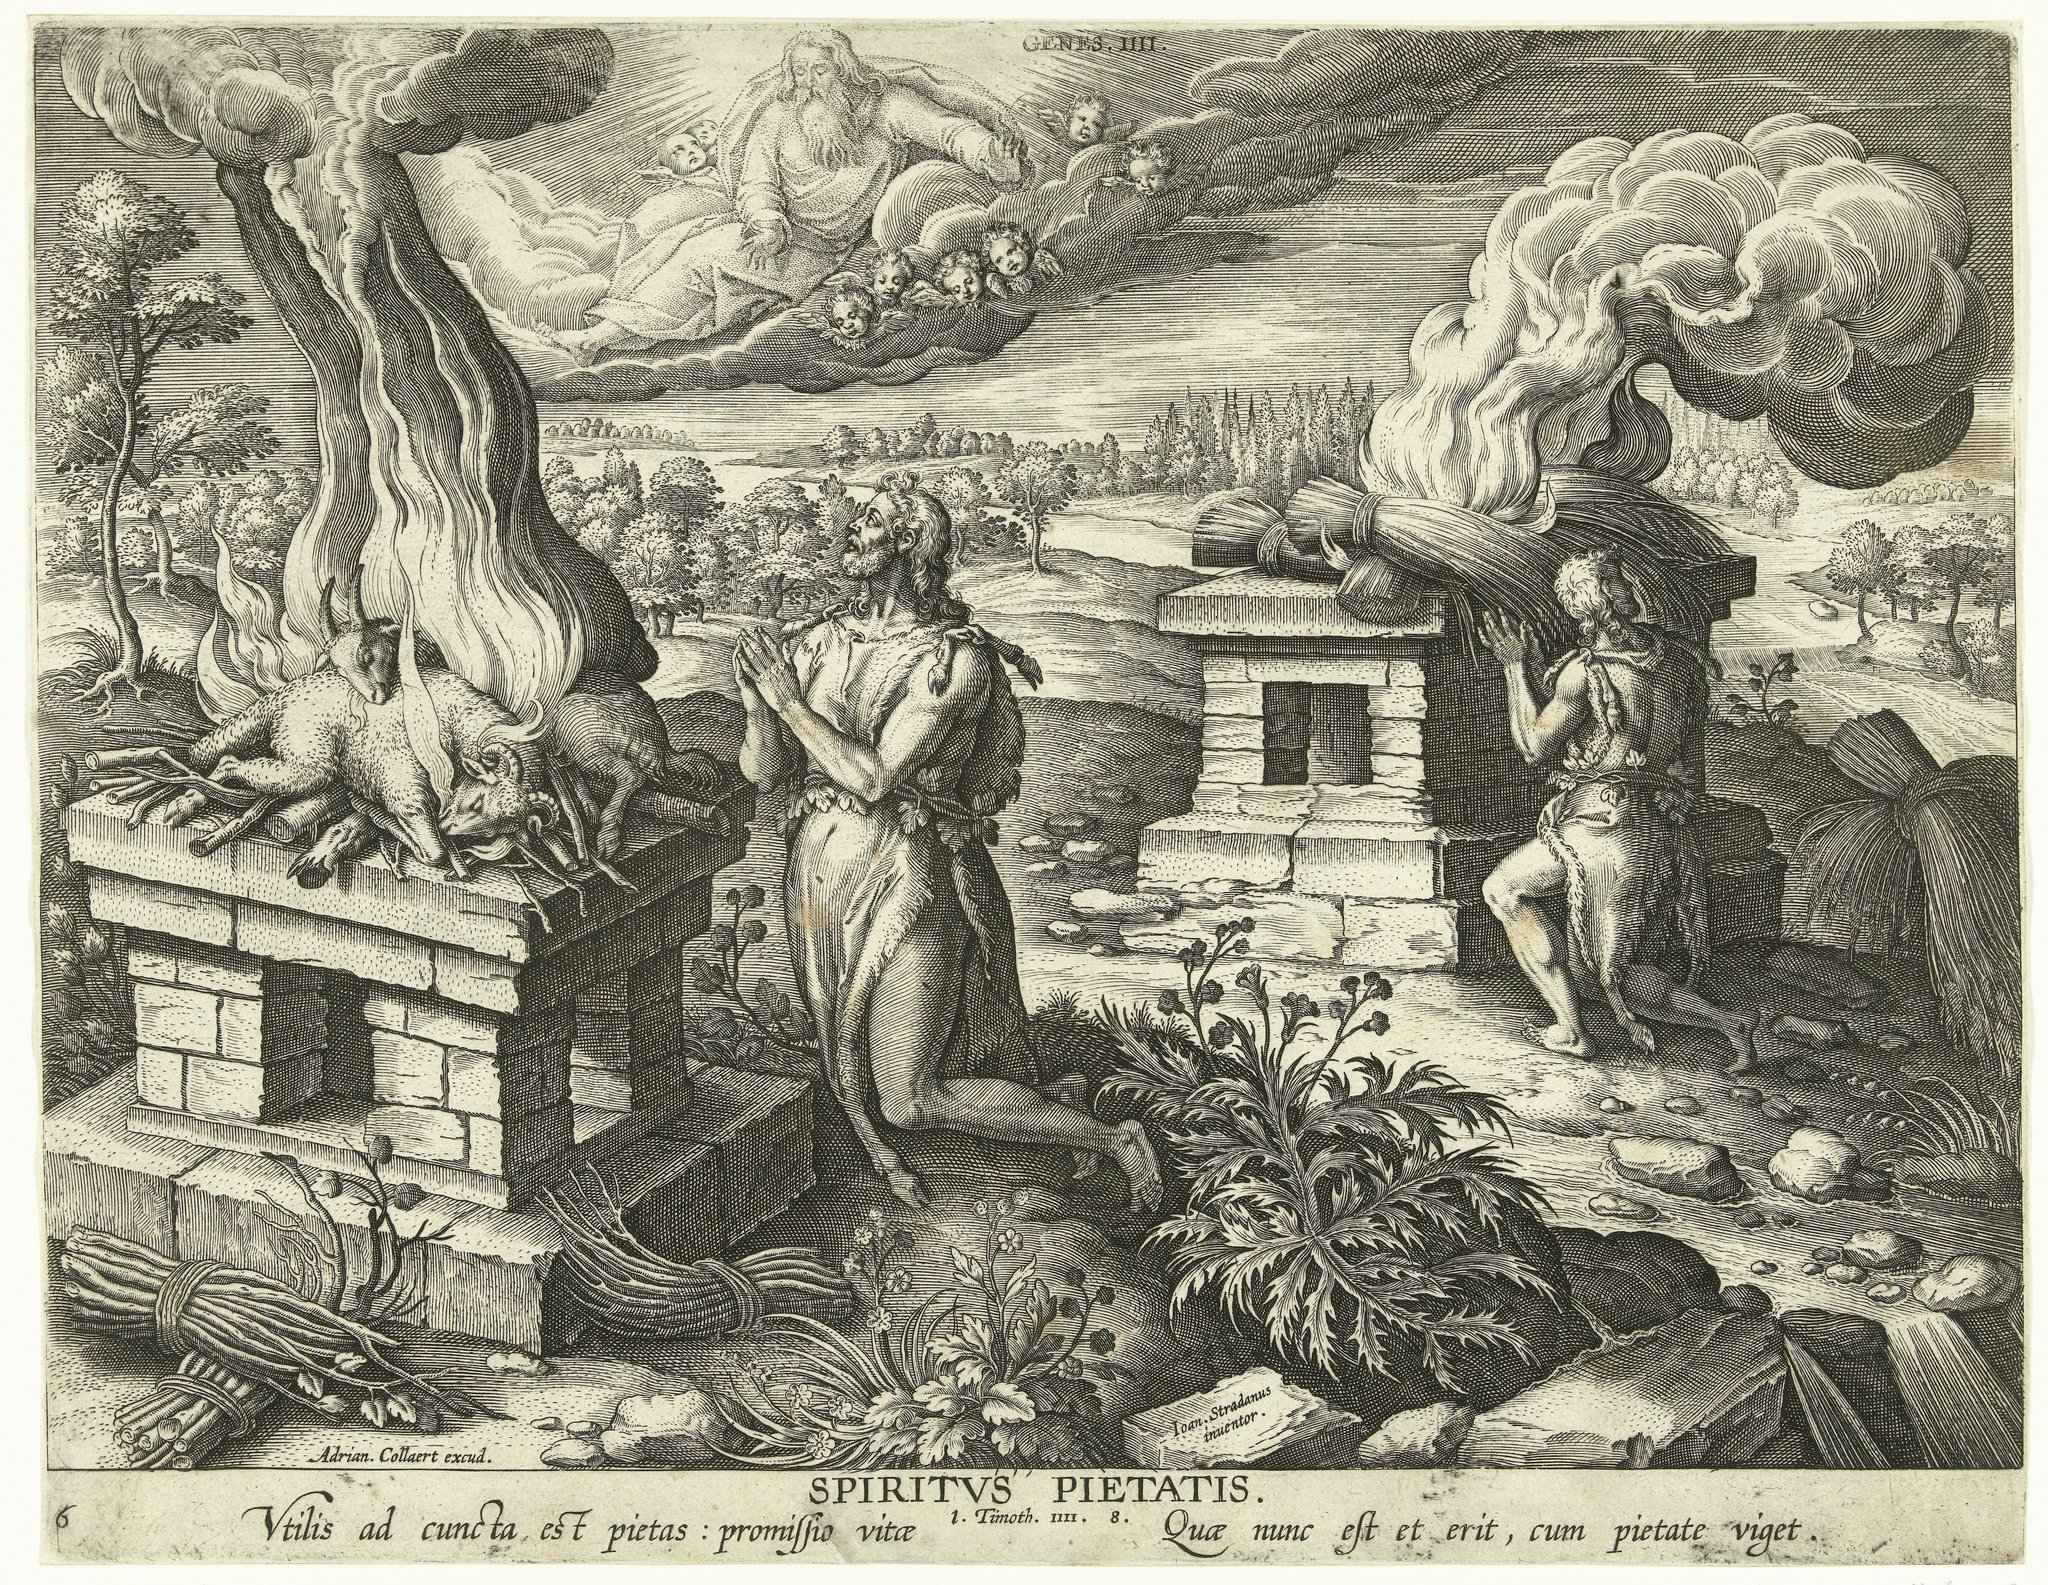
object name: print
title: Zeven gaven van de Heilige Geest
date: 1593-1597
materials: paper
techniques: engraving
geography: antwerp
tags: the fume of abel's sacrifice goes straight to heaven, whereas the smoke of cain's offering is beaten down, god (or the hand of god) appears and blesses abel ~ sacrifice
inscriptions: collector's mark: Lugt 2228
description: De offers van Kaïn en Abel (Genisis 4:3-4). De prent toont de passage waar Abel zijn godsdienstigheid demonstreert. Op de voorgrond Abels offeraltaar, waarop schapen aan God worden geofferd. De rook van het offer stijgt omhoog. Op de achtergrond, Kaïns offeraltaar, waarop korenschoven worden geofferd. De rook gaat omlaag. Boven in de lucht verschijnt God in de wolken. God keurt Abels offer goed. De prent heeft een Latijns onderschrift. De prent is deel van een serie met de verschillende gaven van de Heilige Geest.